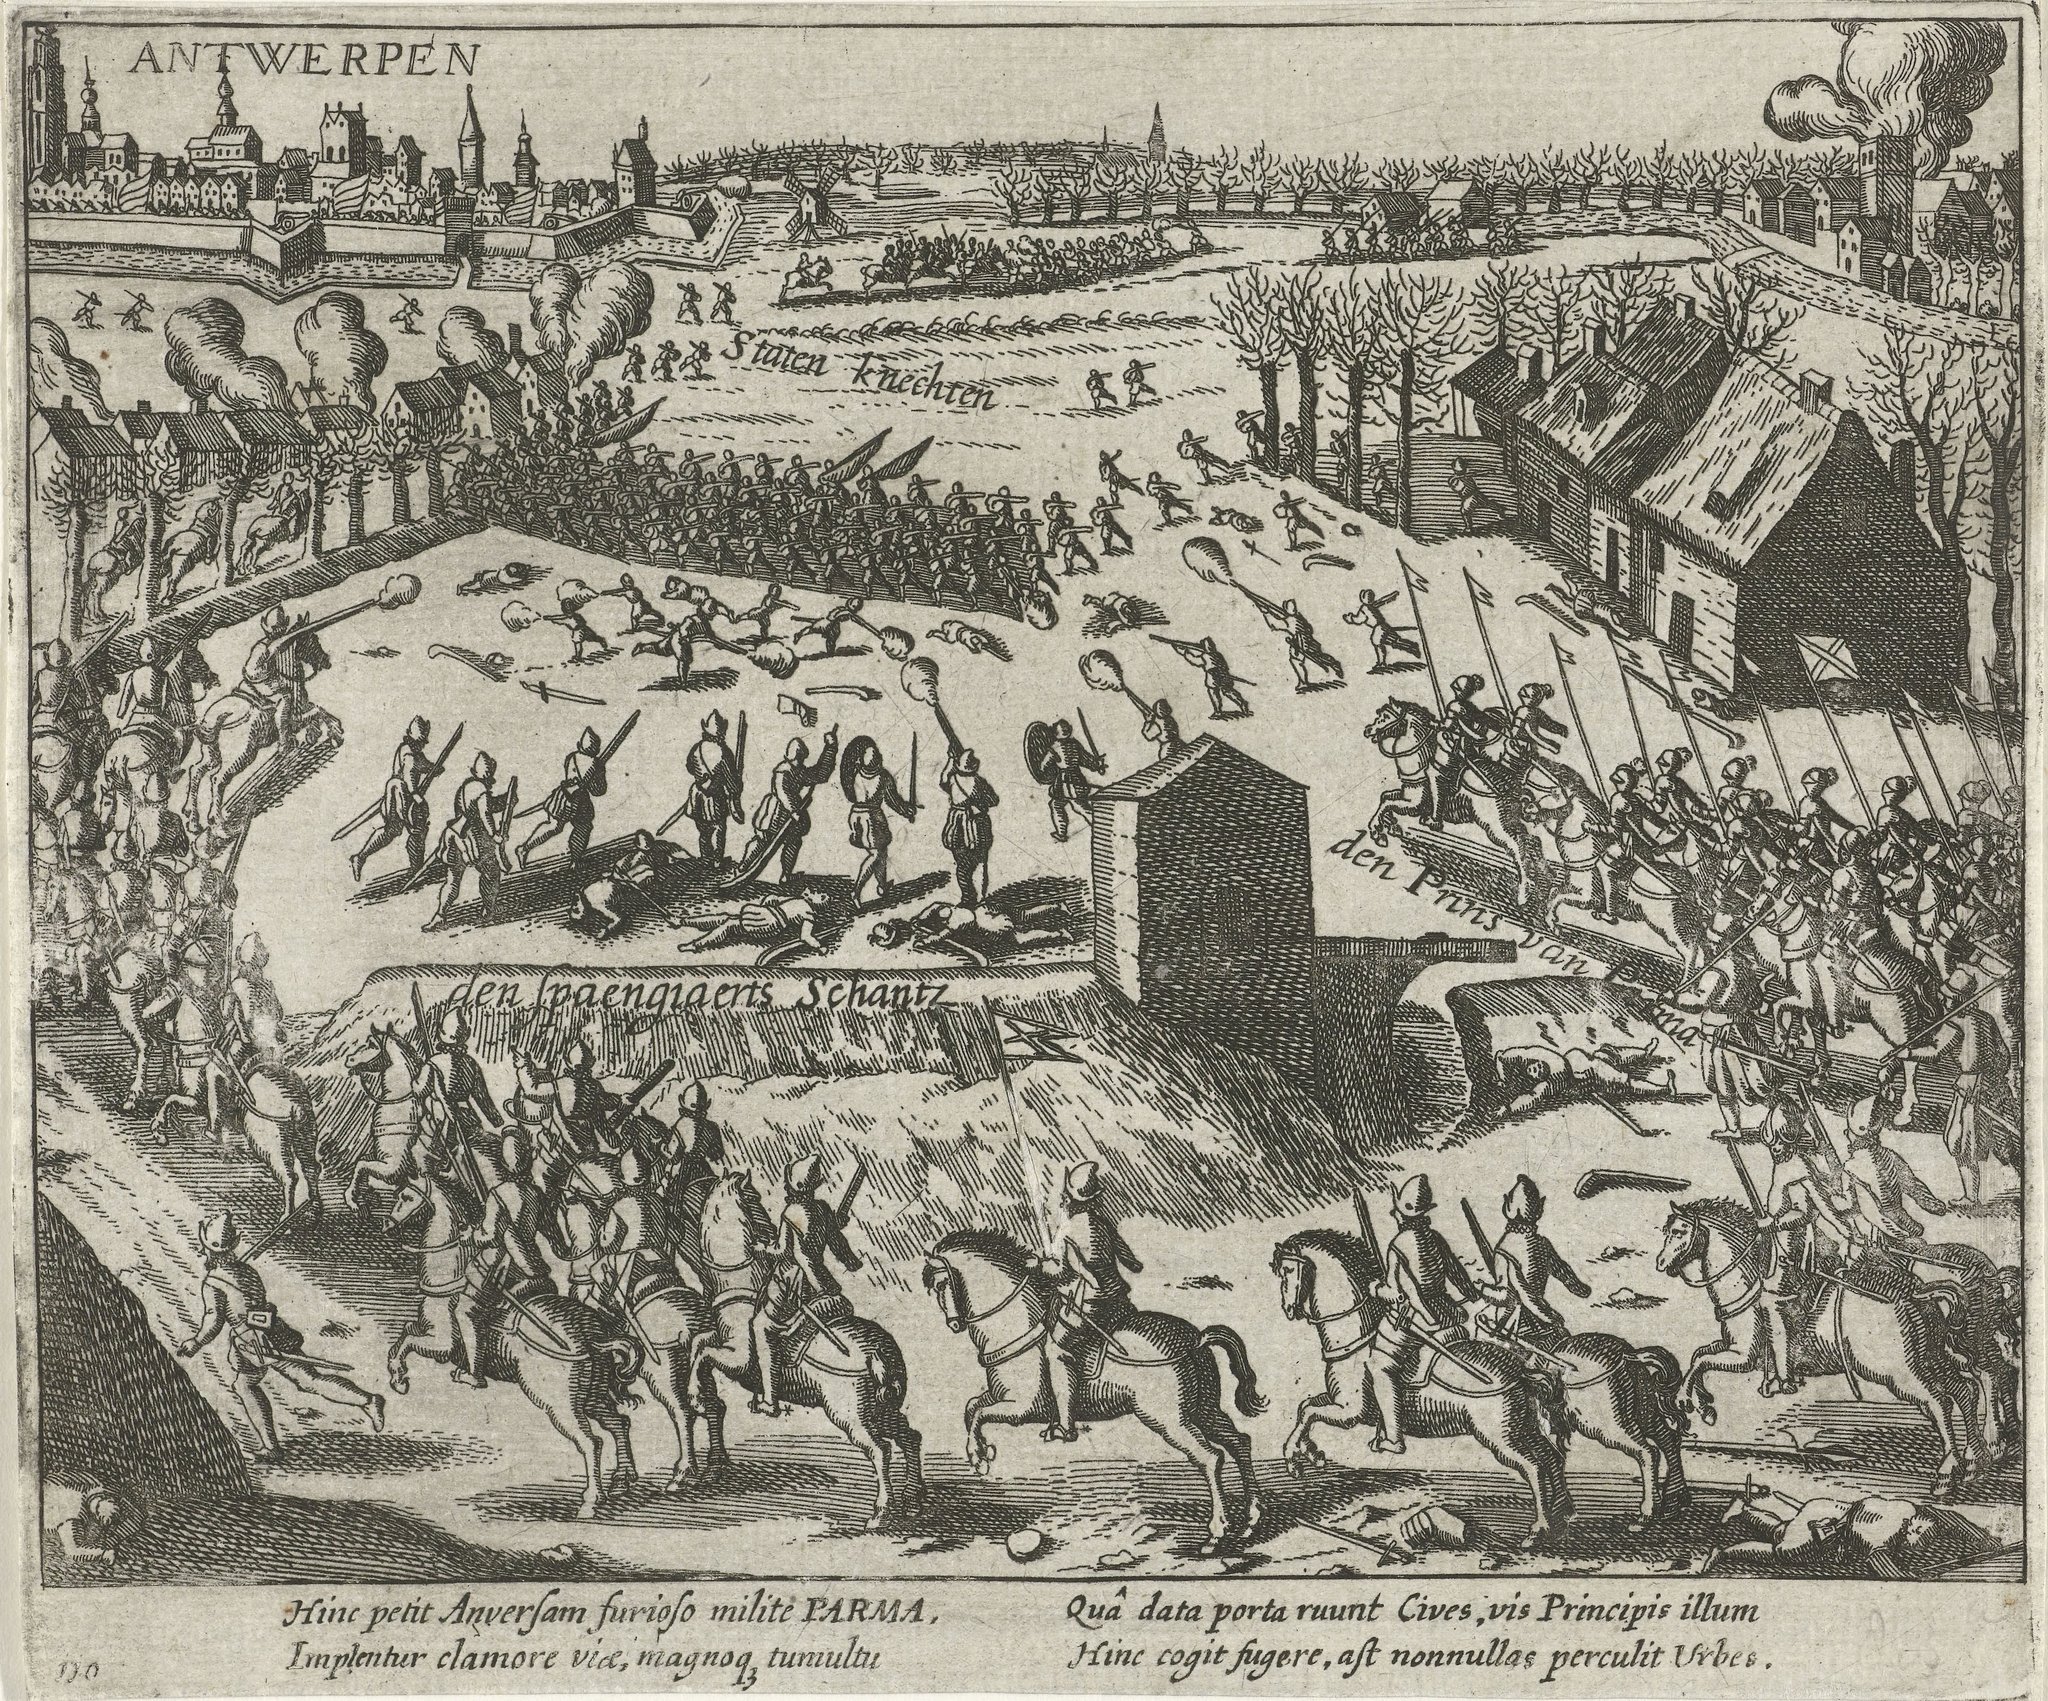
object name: history print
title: Slag bij Borgerhout, 1579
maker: Anonymous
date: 1613-1615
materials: paper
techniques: etching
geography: northern netherlands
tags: rome, alessandro farnese (landvoogd van de nederlanden en hertog van parma en piacenza), battle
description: Slag bij Borgerhout bij Antwerpen, 2 maart 1579, tussen het Staatse leger en het leger van de hertog van Parma. Op de voorgrond Spaanse ruiters en een Spaanse schans, links de brandende huizen van Borgerhout in de verte Antwerpen. Met onderschrift van 4 regels in het Latijn. Genummerd: 110. Bedrukt op achterzijde met tekst in het Latijn.